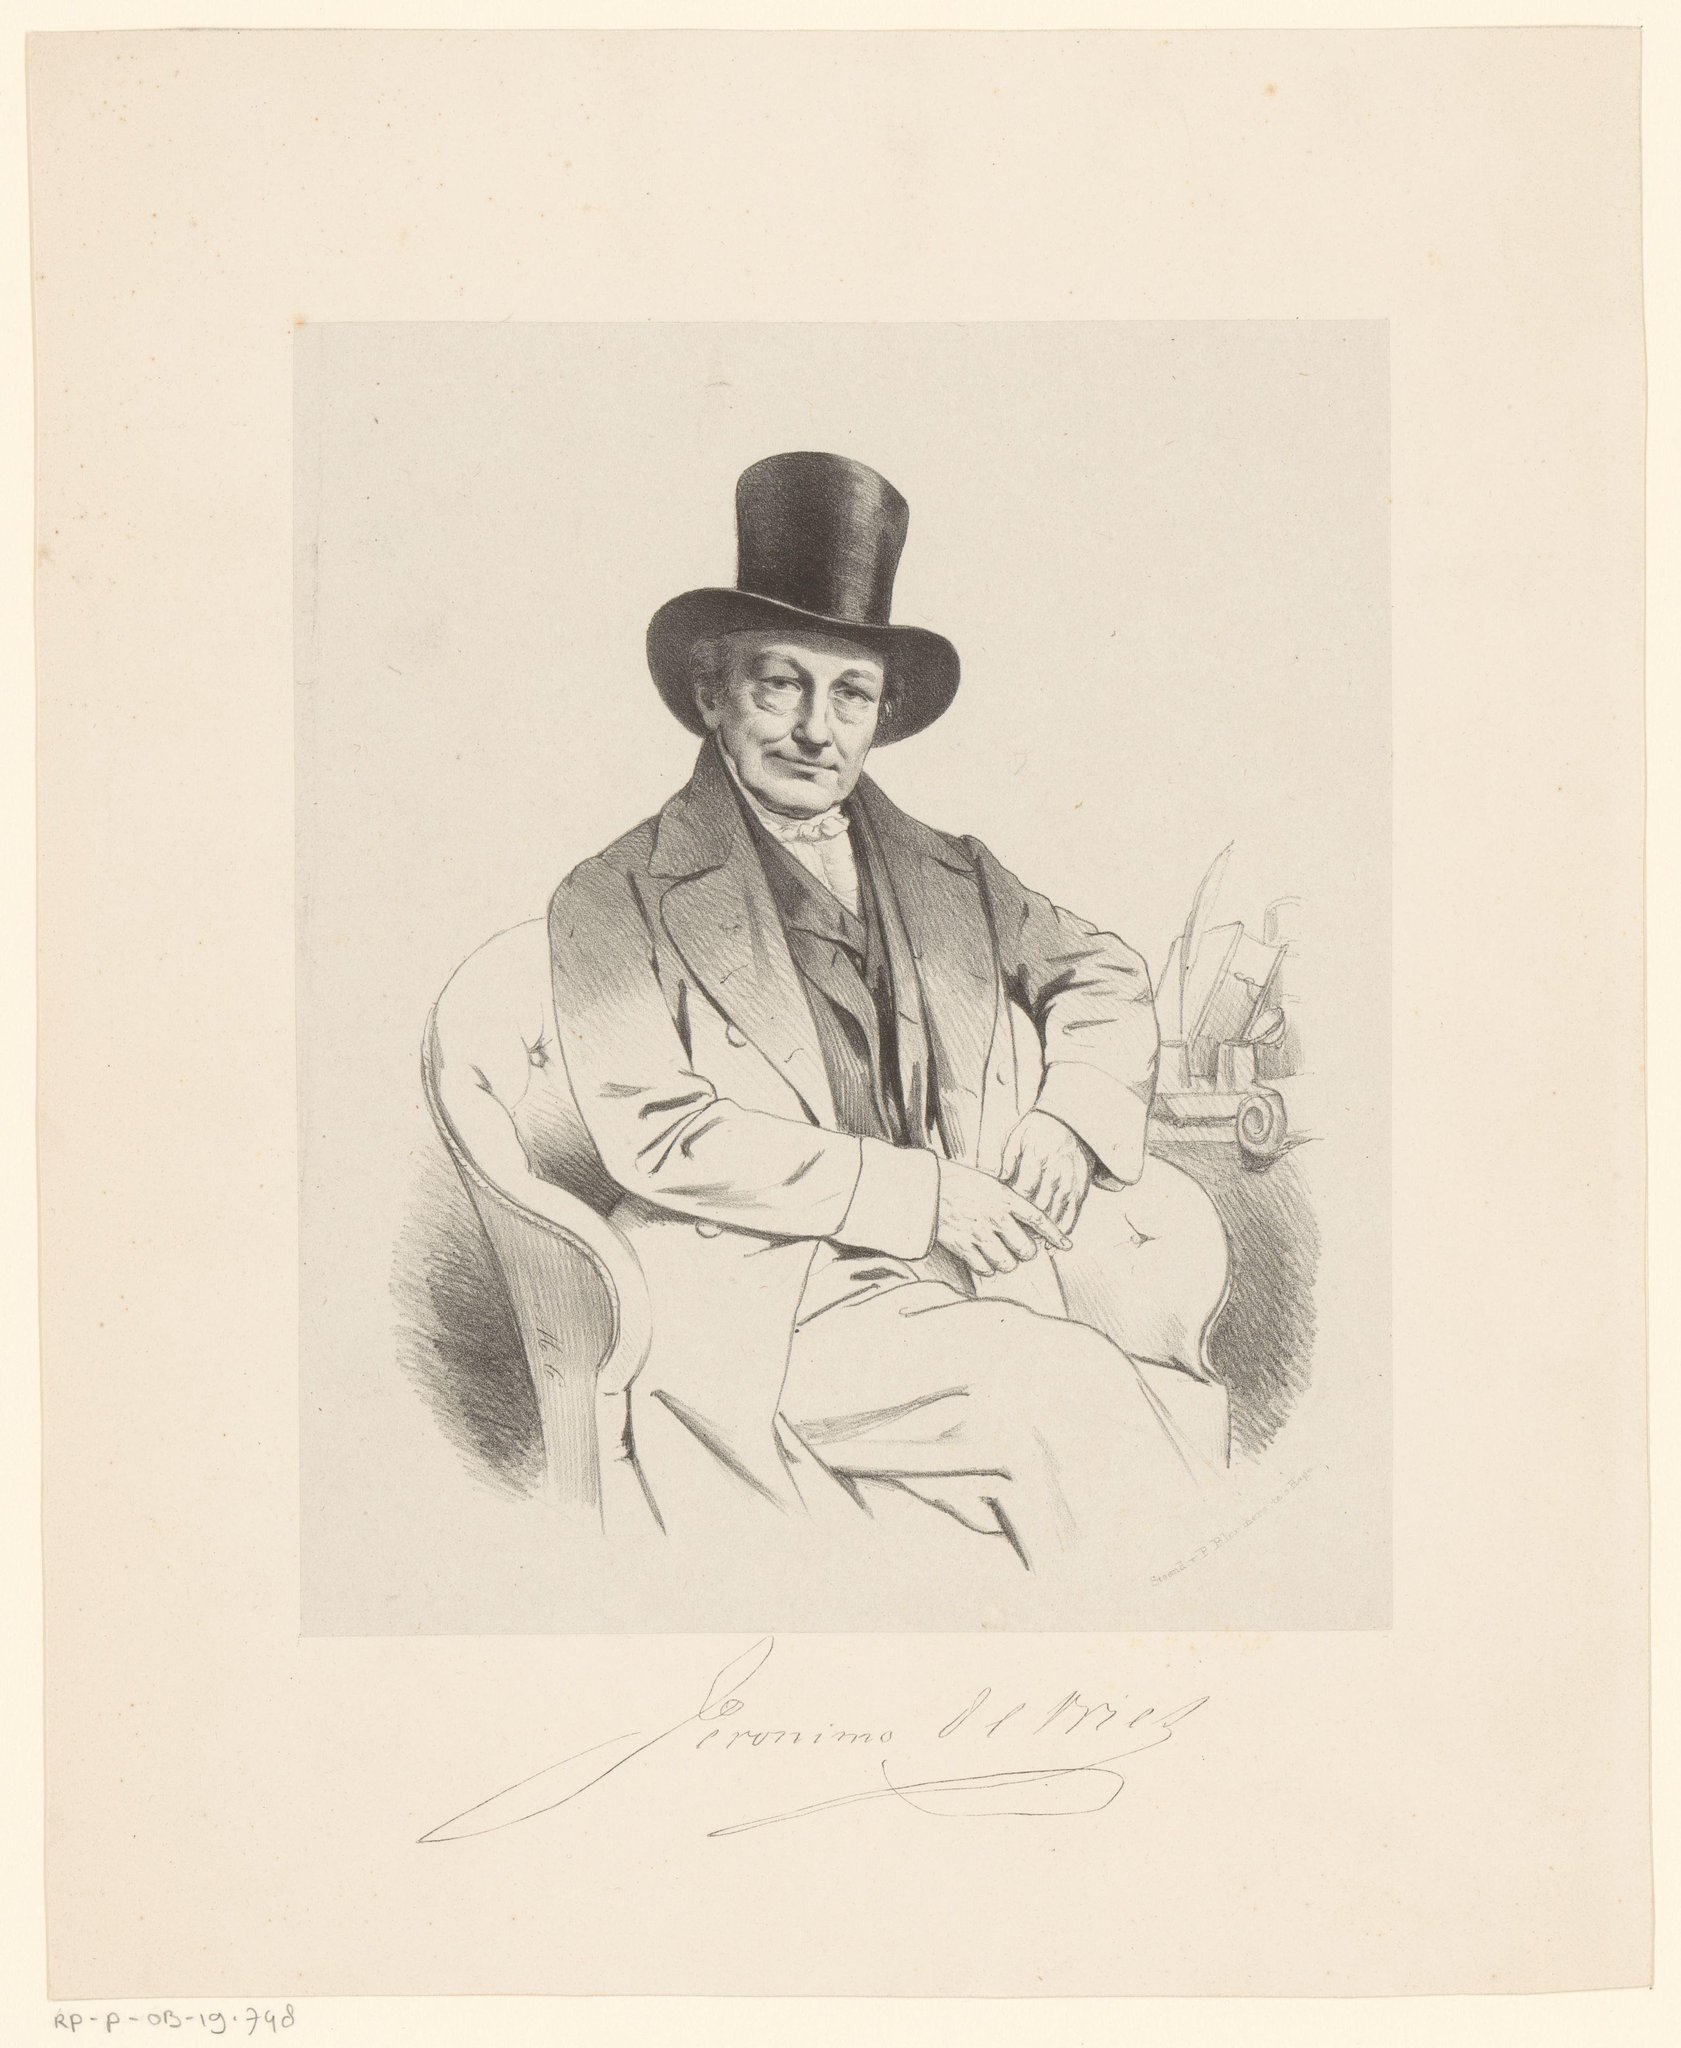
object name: print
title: Portret van Jeronimo de Vries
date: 1842-1887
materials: paper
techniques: lithograph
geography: amsterdam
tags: jeronimo de vries, historical persons (+ three-quarter length portrait), head-gear: top hat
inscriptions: collector's mark: Lugt 2228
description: Onder het portret de signatuur van de geportretteerde.